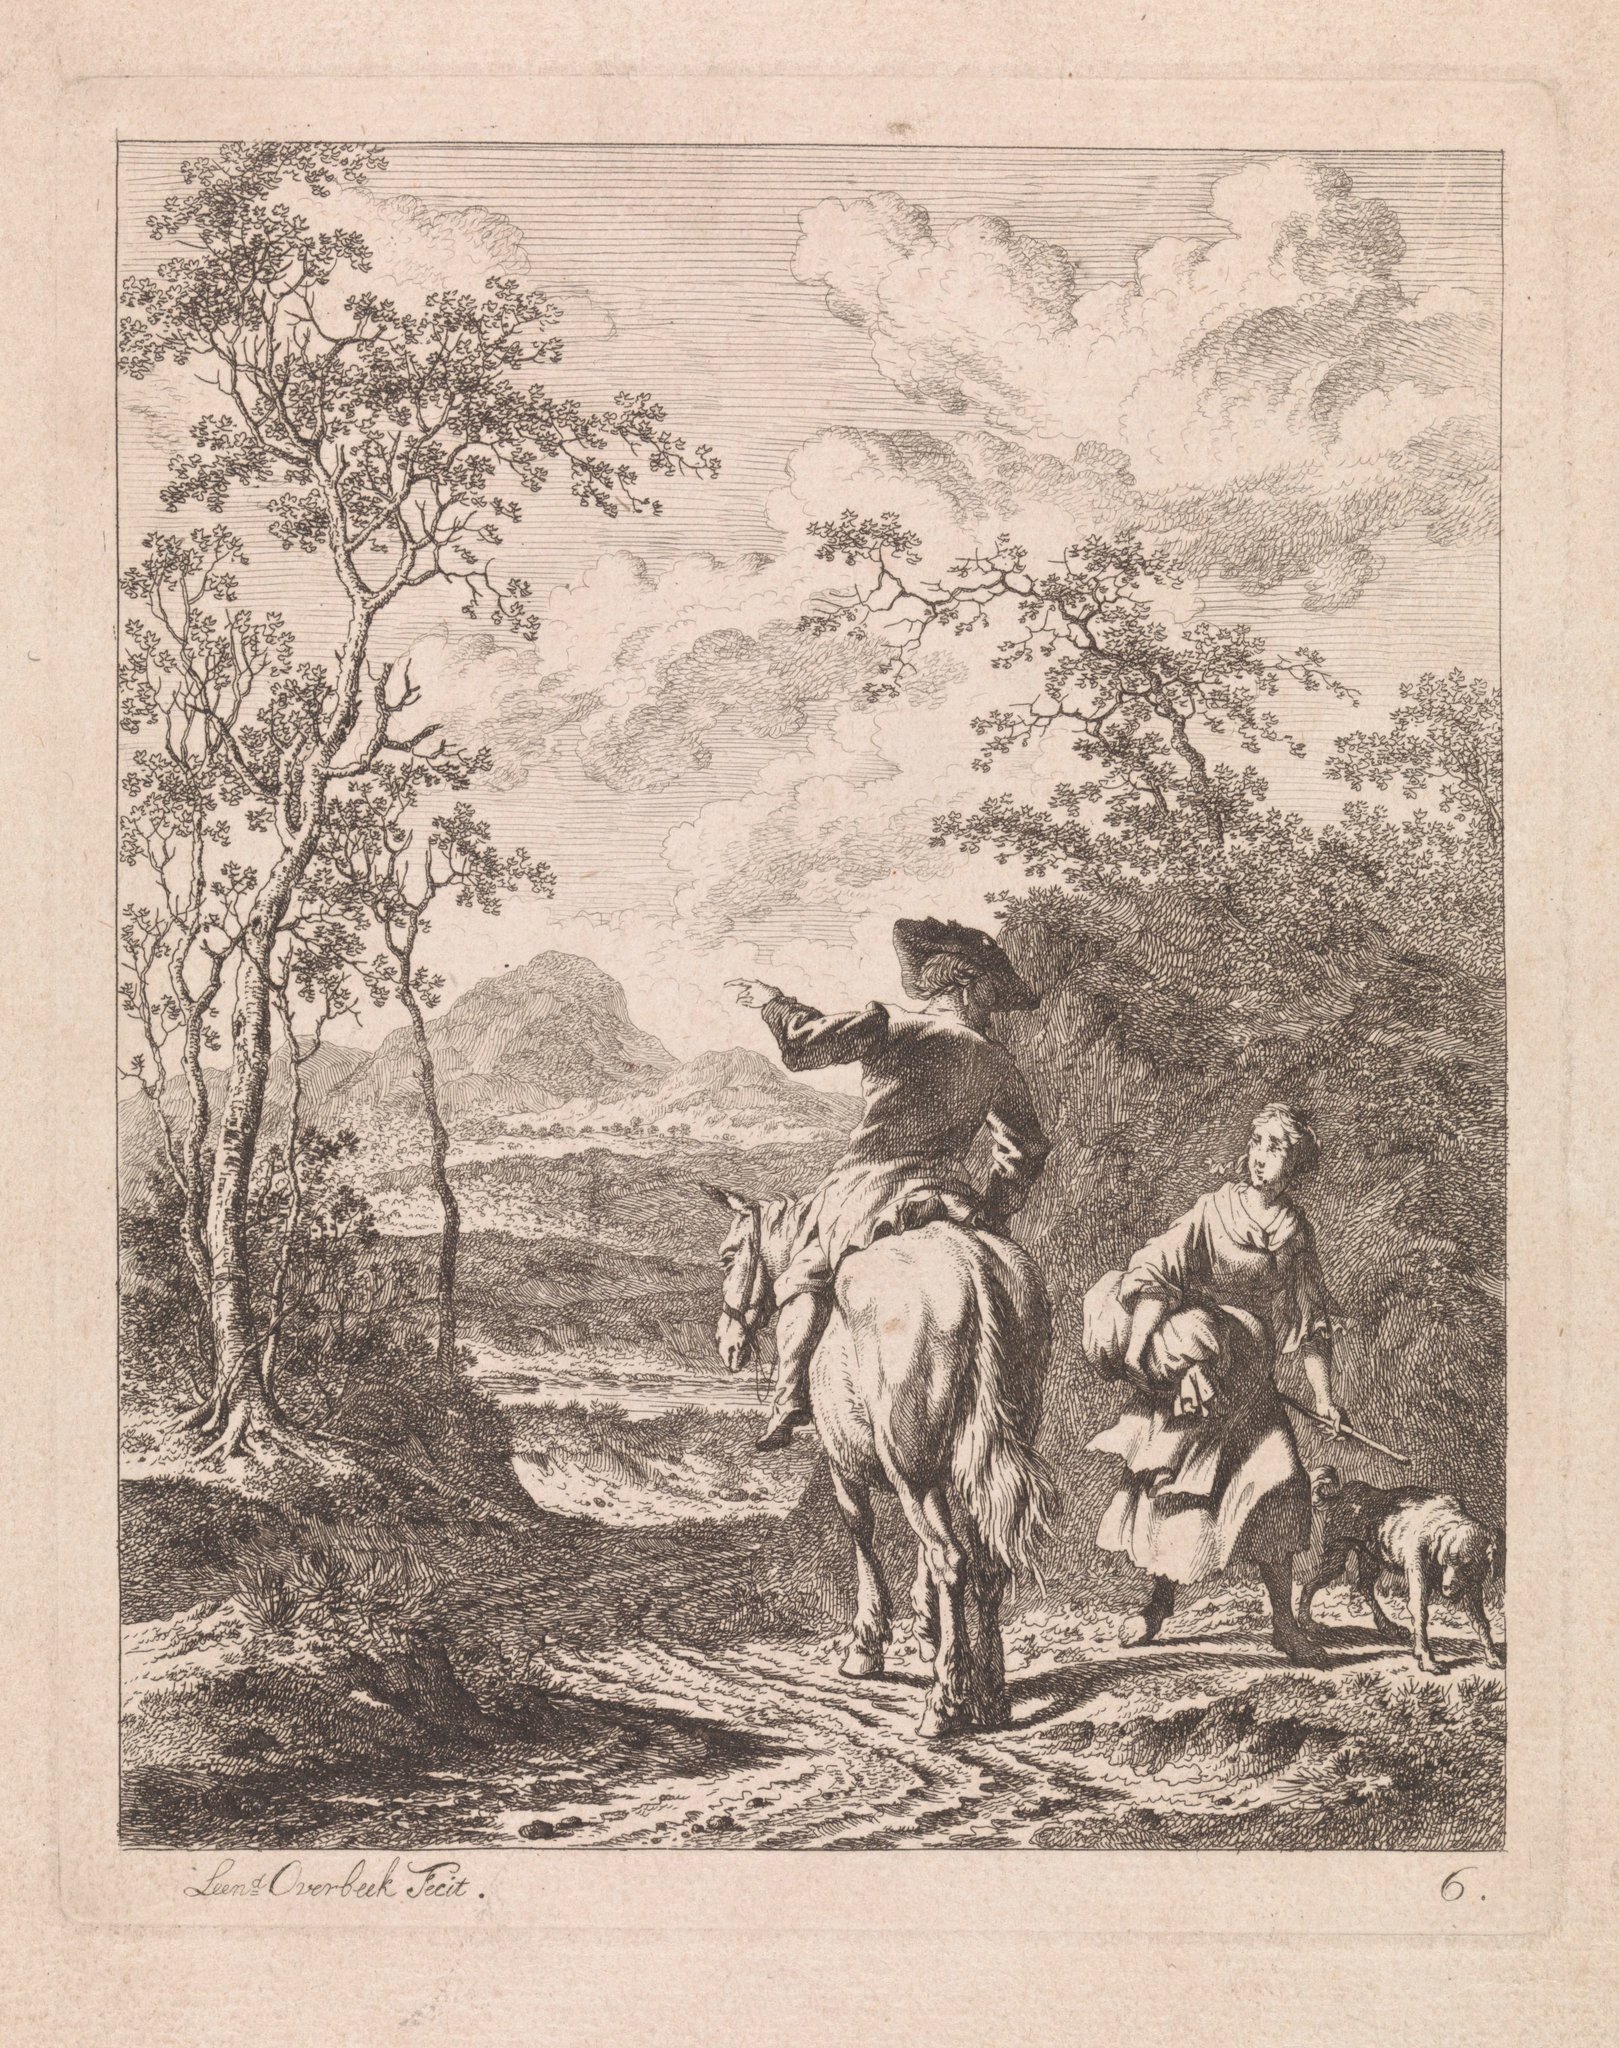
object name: print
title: Ruiter die de weg vraagt aan een meisje met hond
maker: leendert overbeek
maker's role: draughtsman, painter, print maker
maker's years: 1752-1815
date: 1791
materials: paper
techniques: etching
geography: haarlem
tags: riding a horse, ass, or mule; rider, horseman, asking the way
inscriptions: collector's mark: Lugt 2228